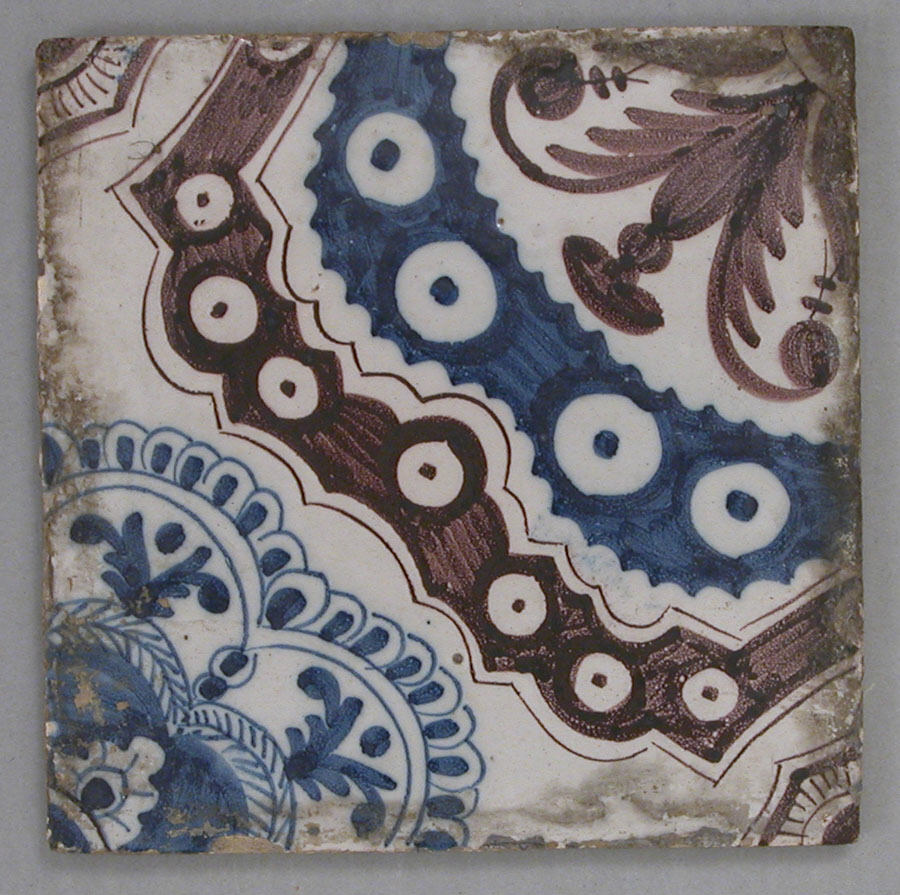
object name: tile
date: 1701-1800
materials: stonepaste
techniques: glazing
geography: north africa